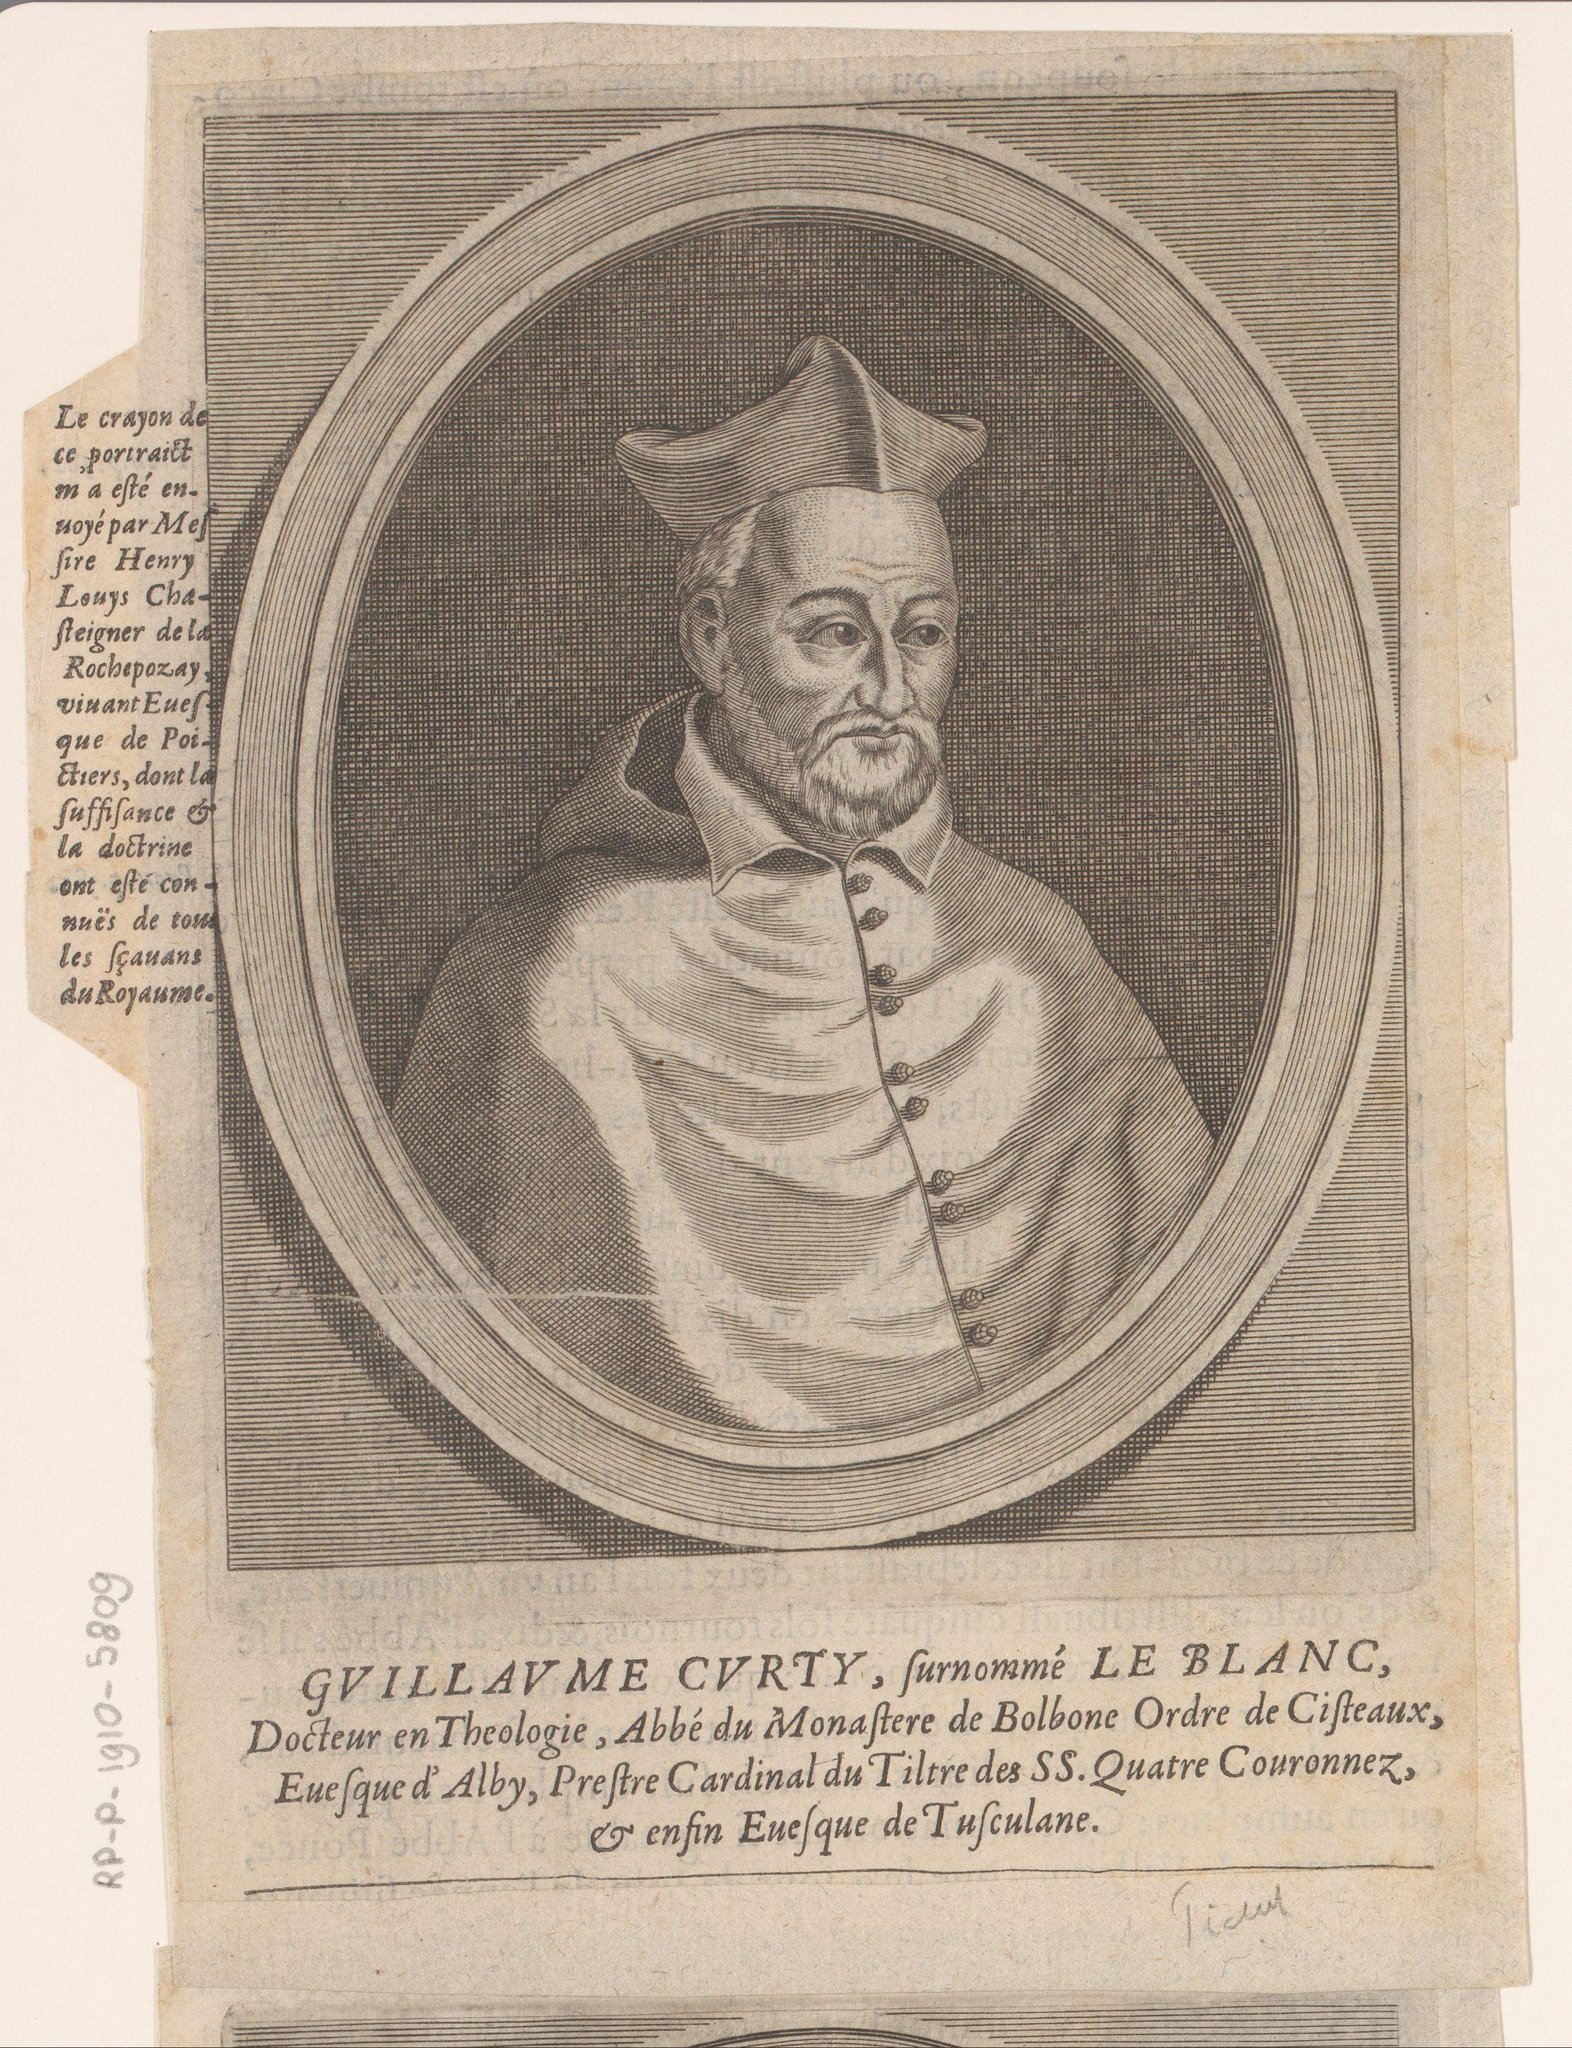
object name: print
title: Guillaume Curty, surnommé Le Blanc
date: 1660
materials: paper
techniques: engraving, etching, letterpress printing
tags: priest, archbishop, bishop, etc. (roman catholic), historical persons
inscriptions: collector's mark: Lugt 2228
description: Prent uit: Du Chesne, François. Histoire de tous les cardinaux françois de naissance, ou qui ont esté promeus au cardinalat. Parijs: François Du Chesne, 1660.